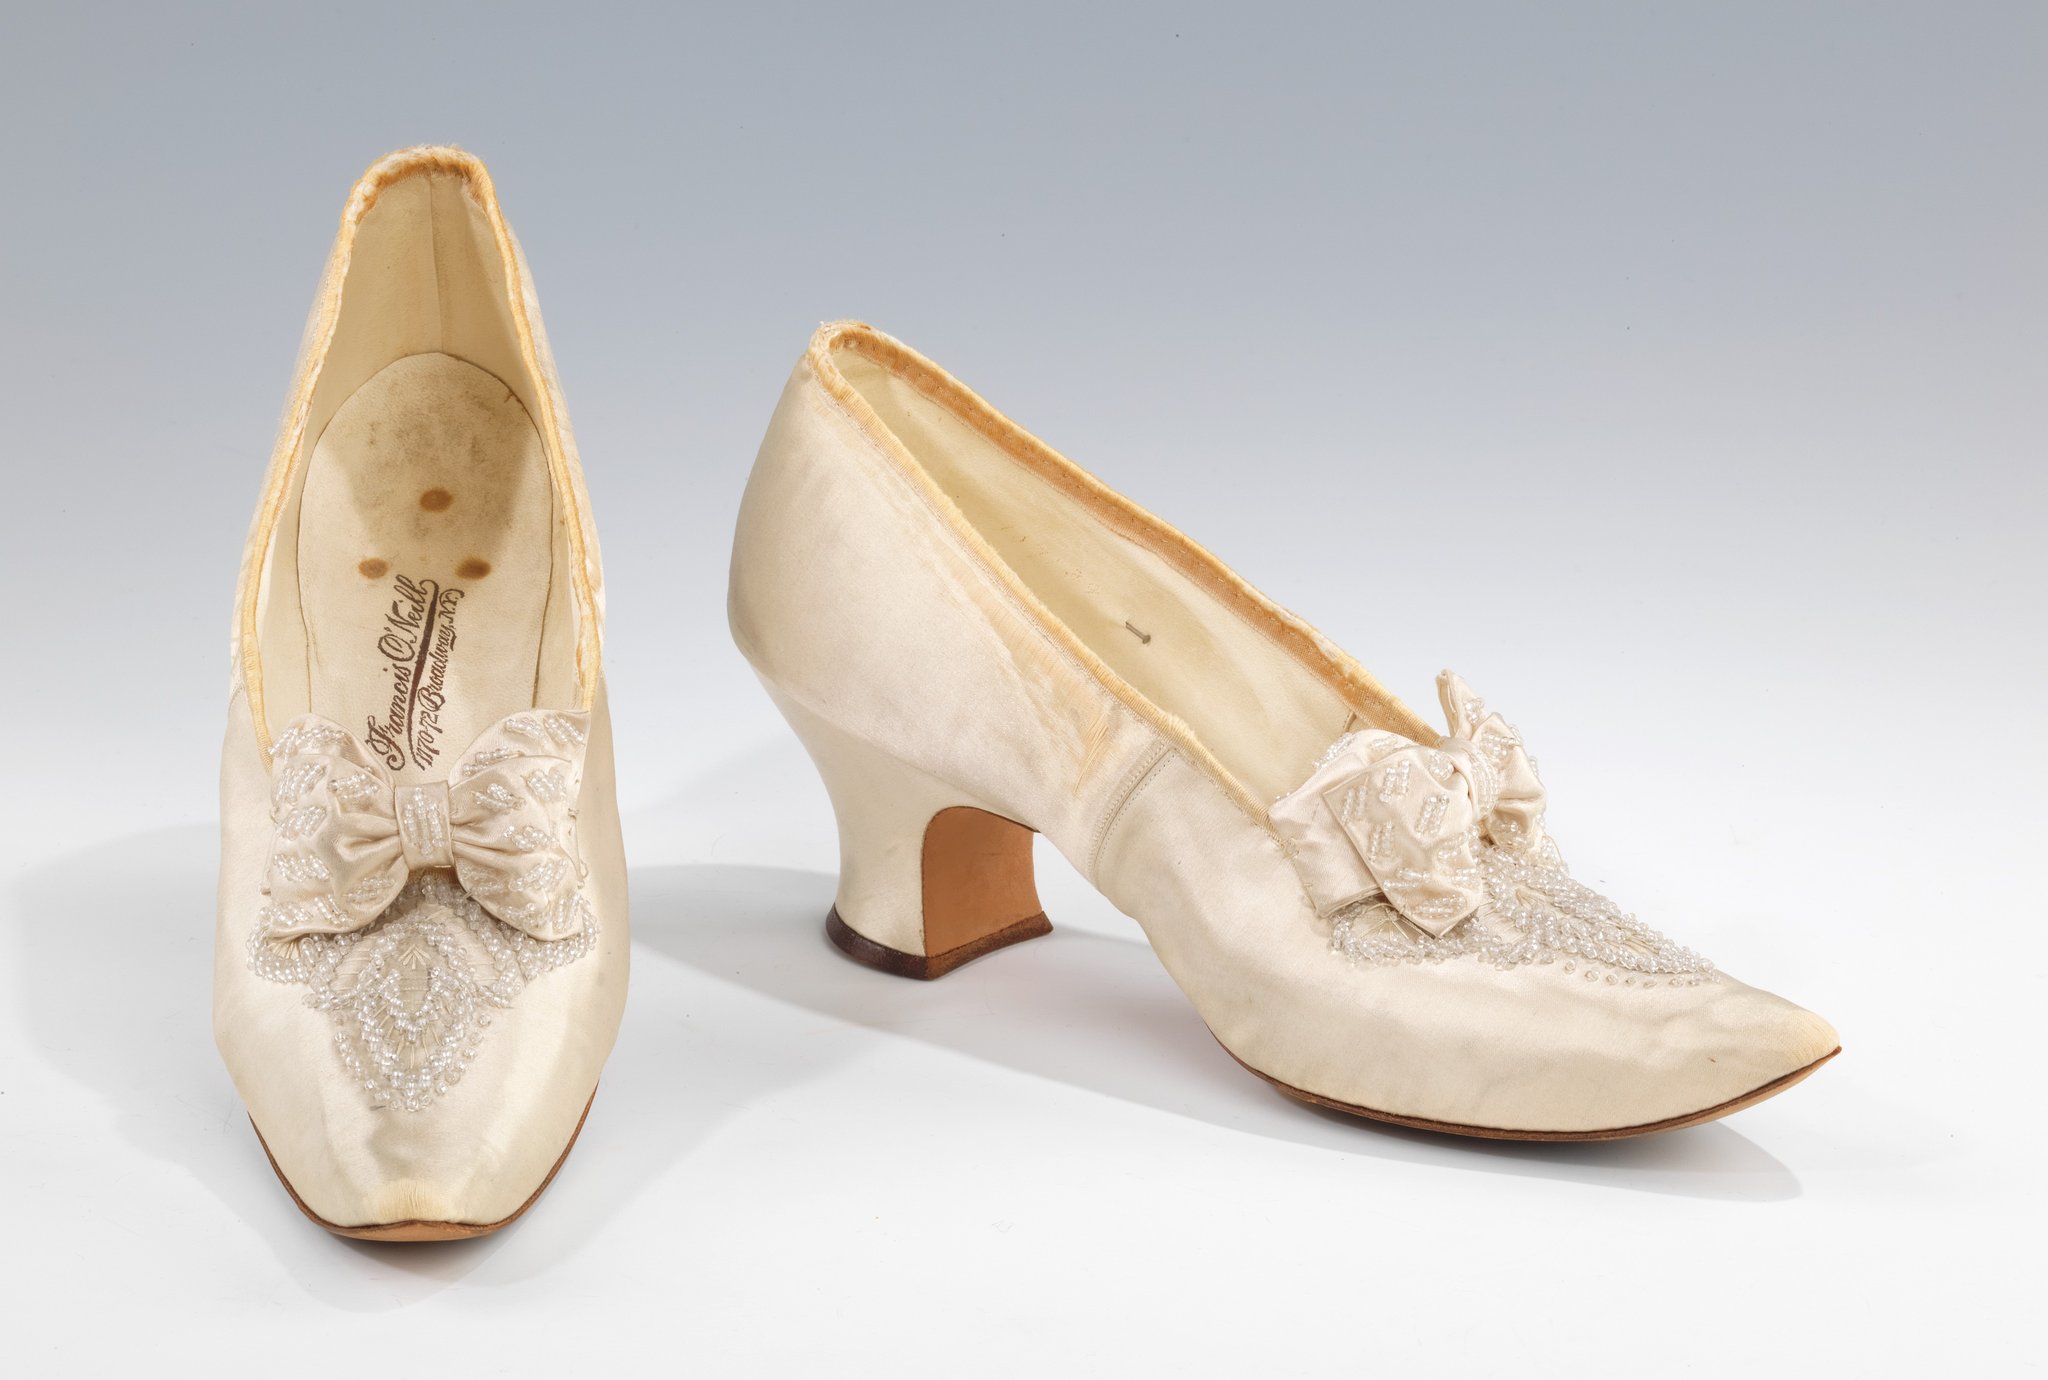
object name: evening slipper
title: Evening slippers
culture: american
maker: francis o'neill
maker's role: department store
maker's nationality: american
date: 1898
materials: silk